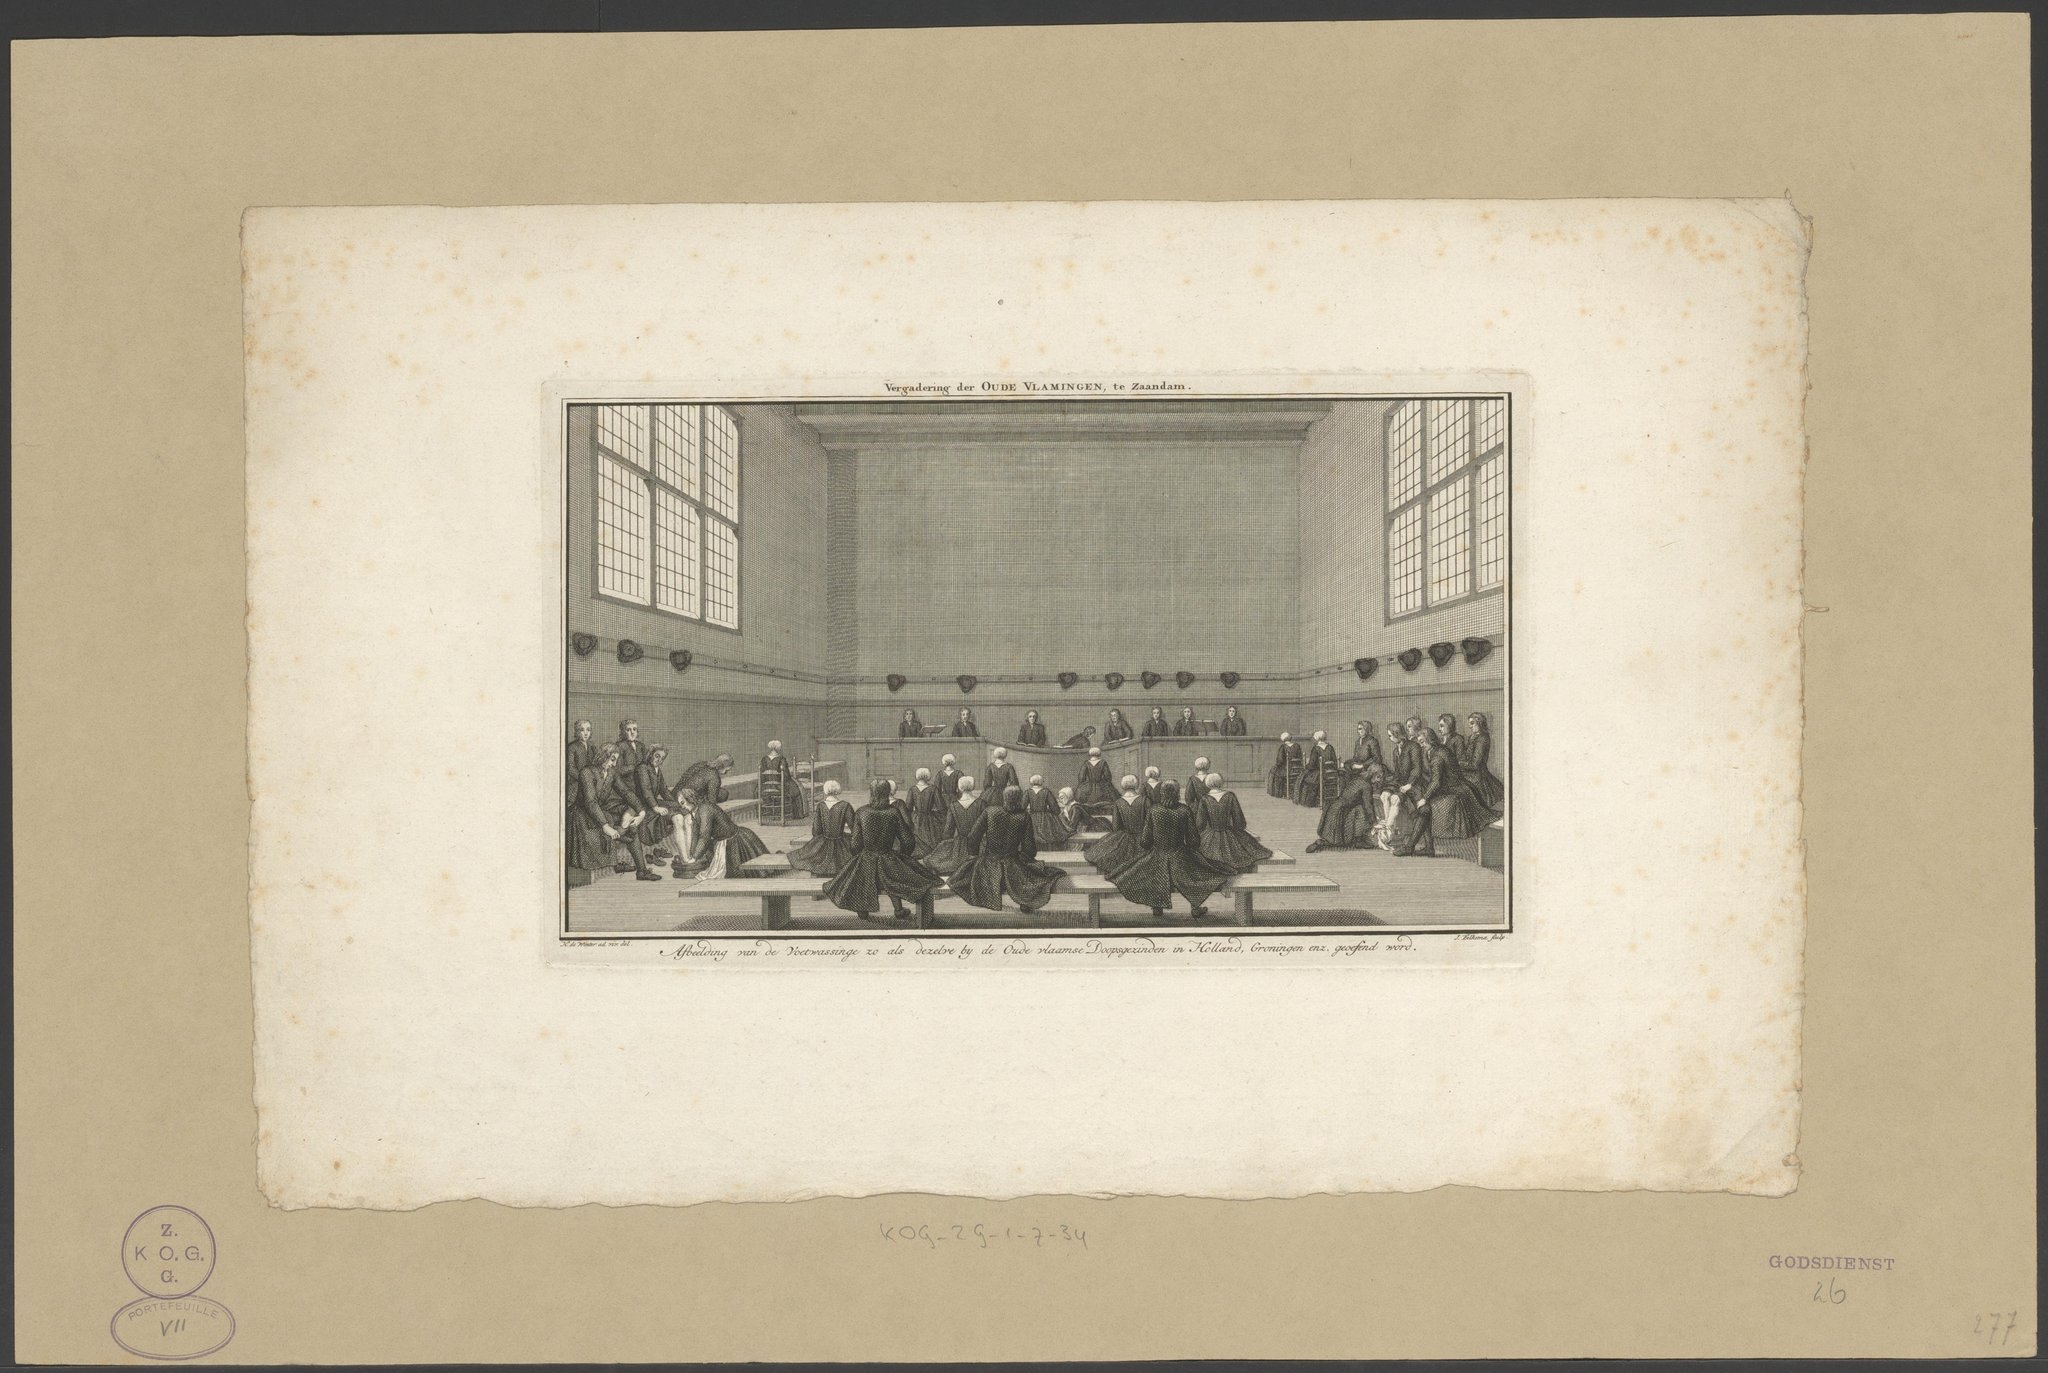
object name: print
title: Vergadering der Oude Vlamingen, te Zaandam. Afbeelding van de Voetwassinge zo als dezelve by de Oude vlaamse Doopsgezinden in Holland, Groningen enz. geoefend word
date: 1743-1750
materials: paper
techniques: etching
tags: washing another person's feet, protestant service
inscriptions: stamp, collector's mark: Lugt 1641, stamp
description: Prent waarschijnlijk uit: Schijn, Hermannus. Geschiedenis dier christenen, welke in de Vereenigde Nederlanden onder de protestanten mennoniten genaamd worden (...). Amsterdam: Kornelis de Wit, 1743. Of uit: Maatschoen, G. Levensbeschryving van eenige voornaame mannen, in hun leven leeraaren, by de Doopsgezinden (...). Amsterdam: Kornelis de Wit, 1750, tussen p. 144 en 145.